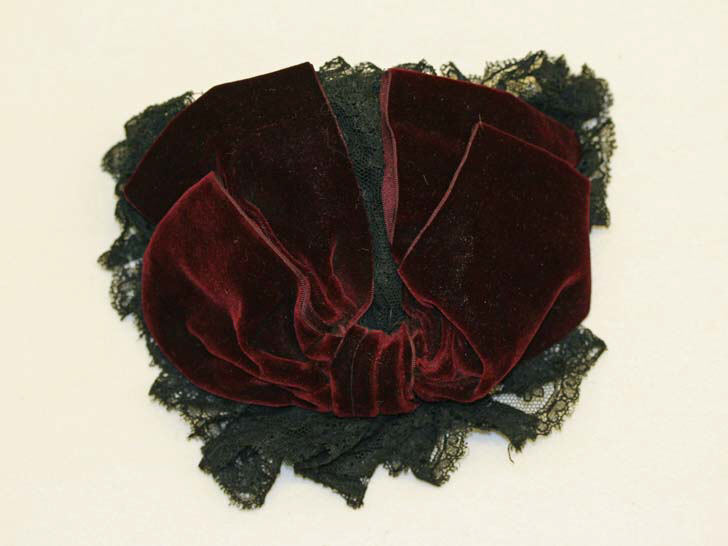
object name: bonnet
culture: american or european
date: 1880-1887